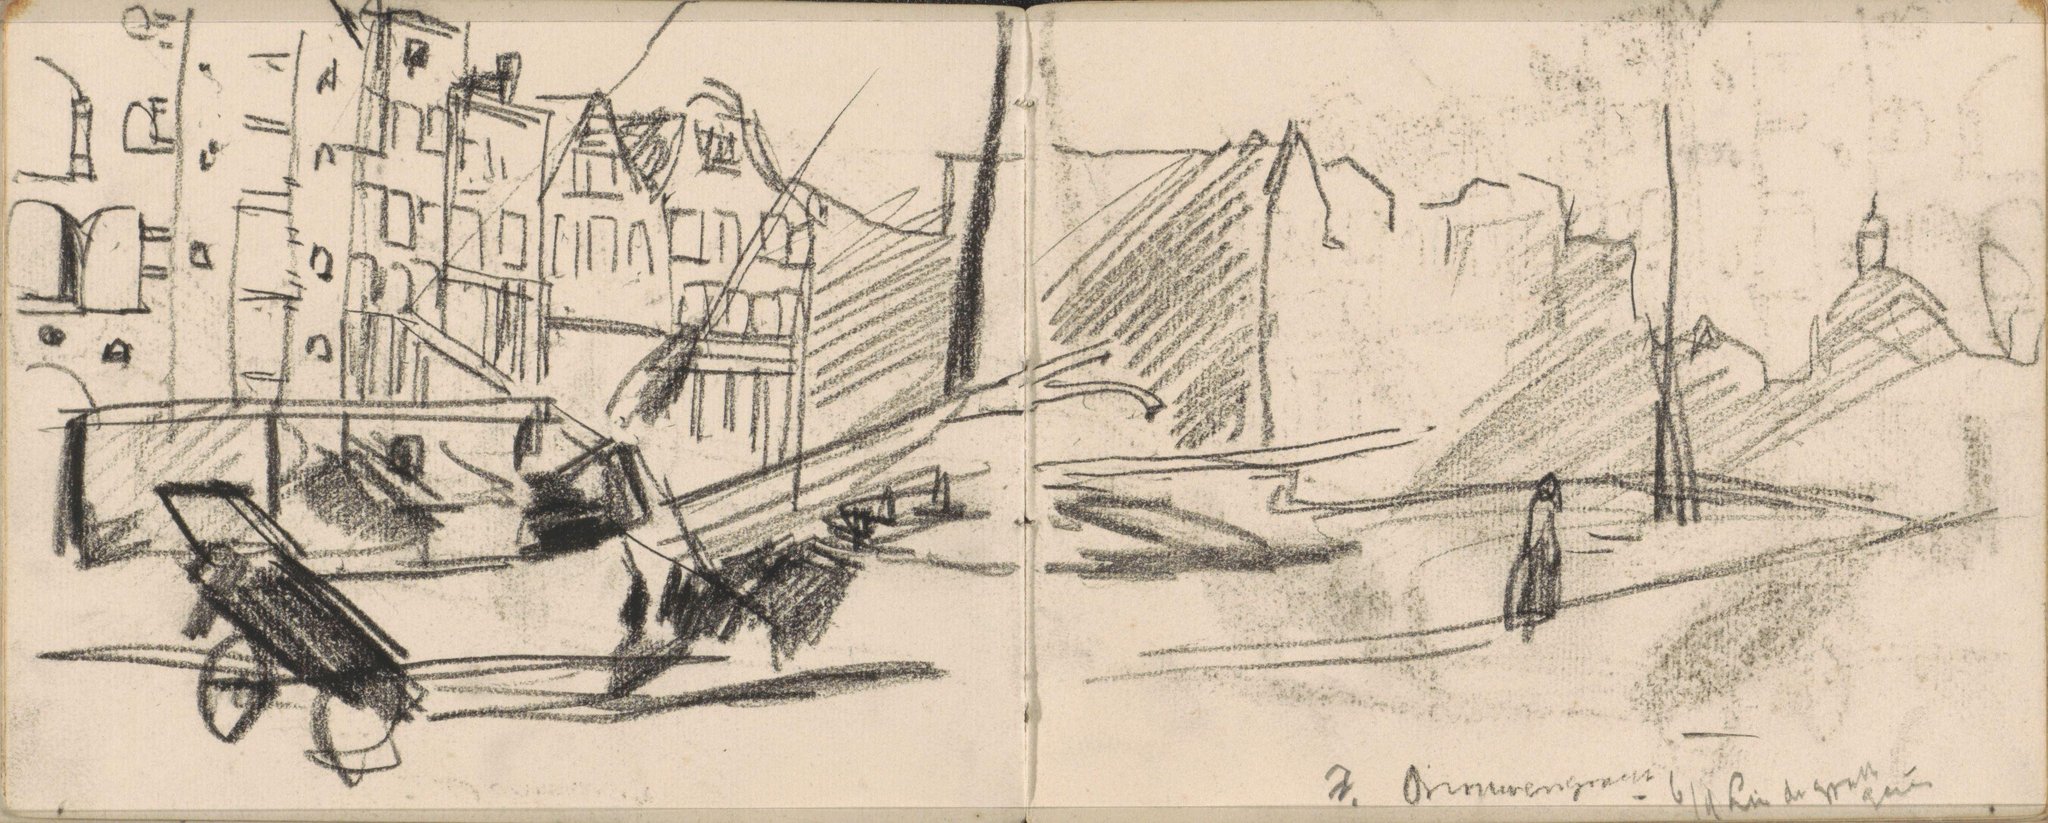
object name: sketchbook leaf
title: Gezicht op de Brouwersgracht te Amsterdam ter hoogte van de Lindengracht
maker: george hendrik breitner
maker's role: draughtsman, painter, print maker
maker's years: 1857-1923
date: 1893-1899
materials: chalk, paper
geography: amsterdam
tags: urban housing, canals, waters (in city) (+ city(-scape) with figures, staffage)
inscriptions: annotation: ‘[...] Brouwersgracht/ b/d Lindengracht gezien’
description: Pagina 13 en pagina 14 uit een schetsboek met 28 bladen.